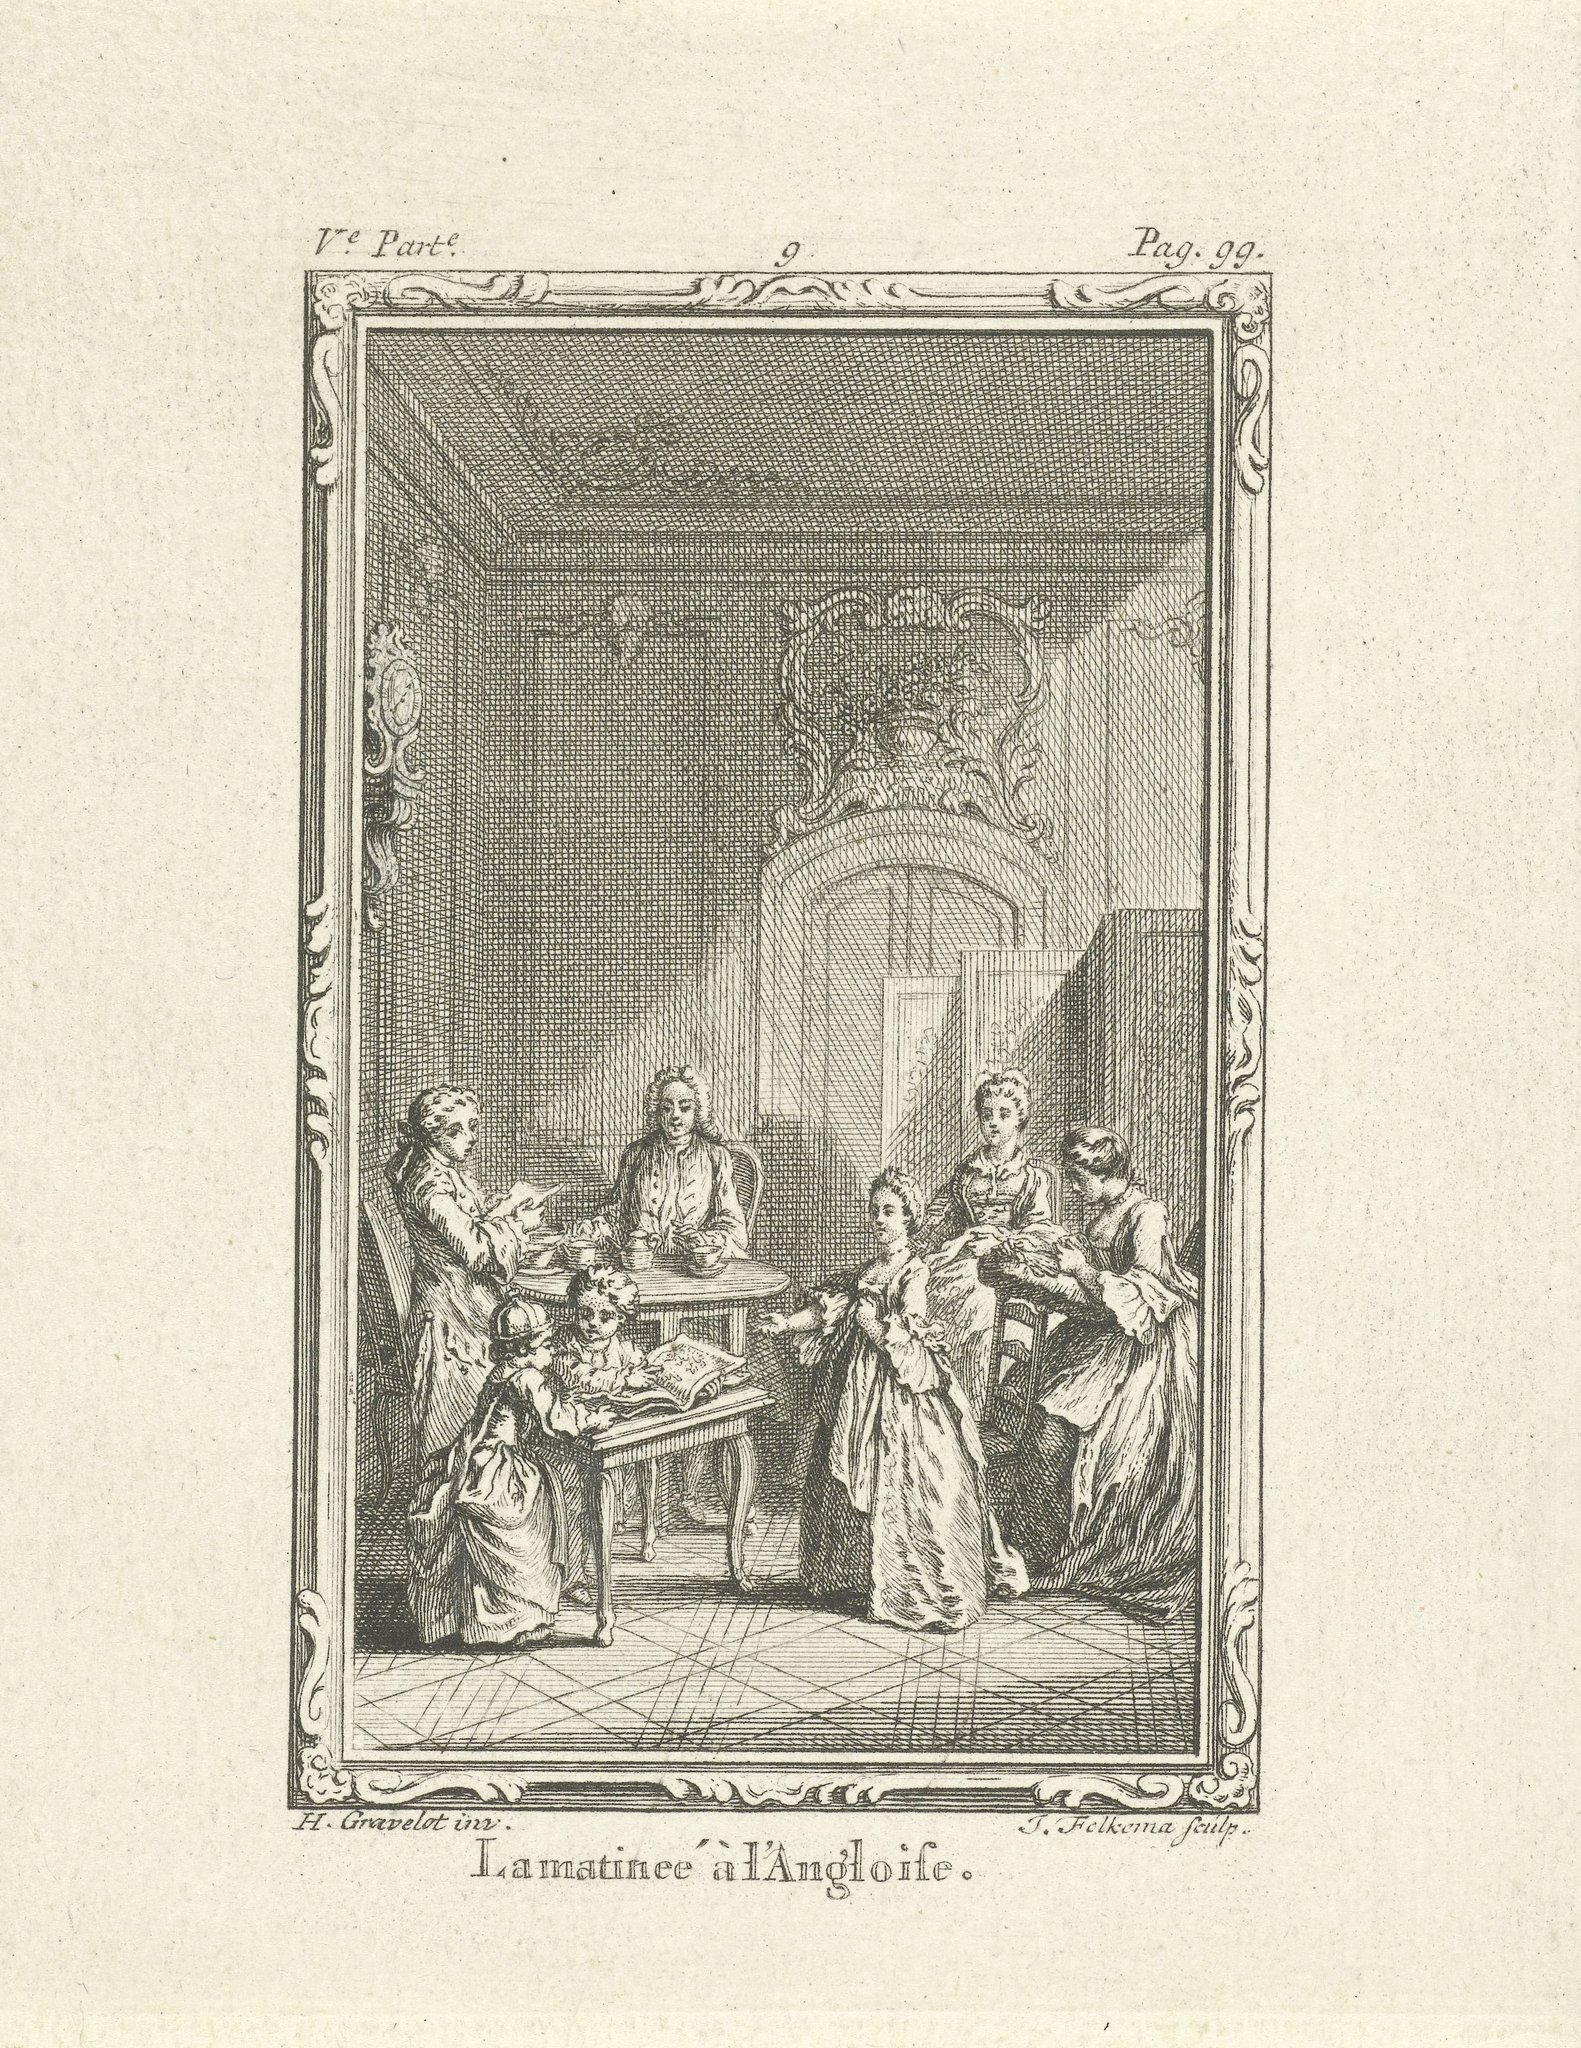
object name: print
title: Gezelschap met kinderen in een interieur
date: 1761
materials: paper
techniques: etching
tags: interior of the house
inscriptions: collector's mark: Lugt 2228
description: Een gezelschap bestaande uit twee heren, twee dames en drie kinderen in een interieur. Onder de voorstelling staat een eenregelig onderschrift in het Frans. Prent links- en rechtsboven gemerkt: Ve. Part - Page 99.